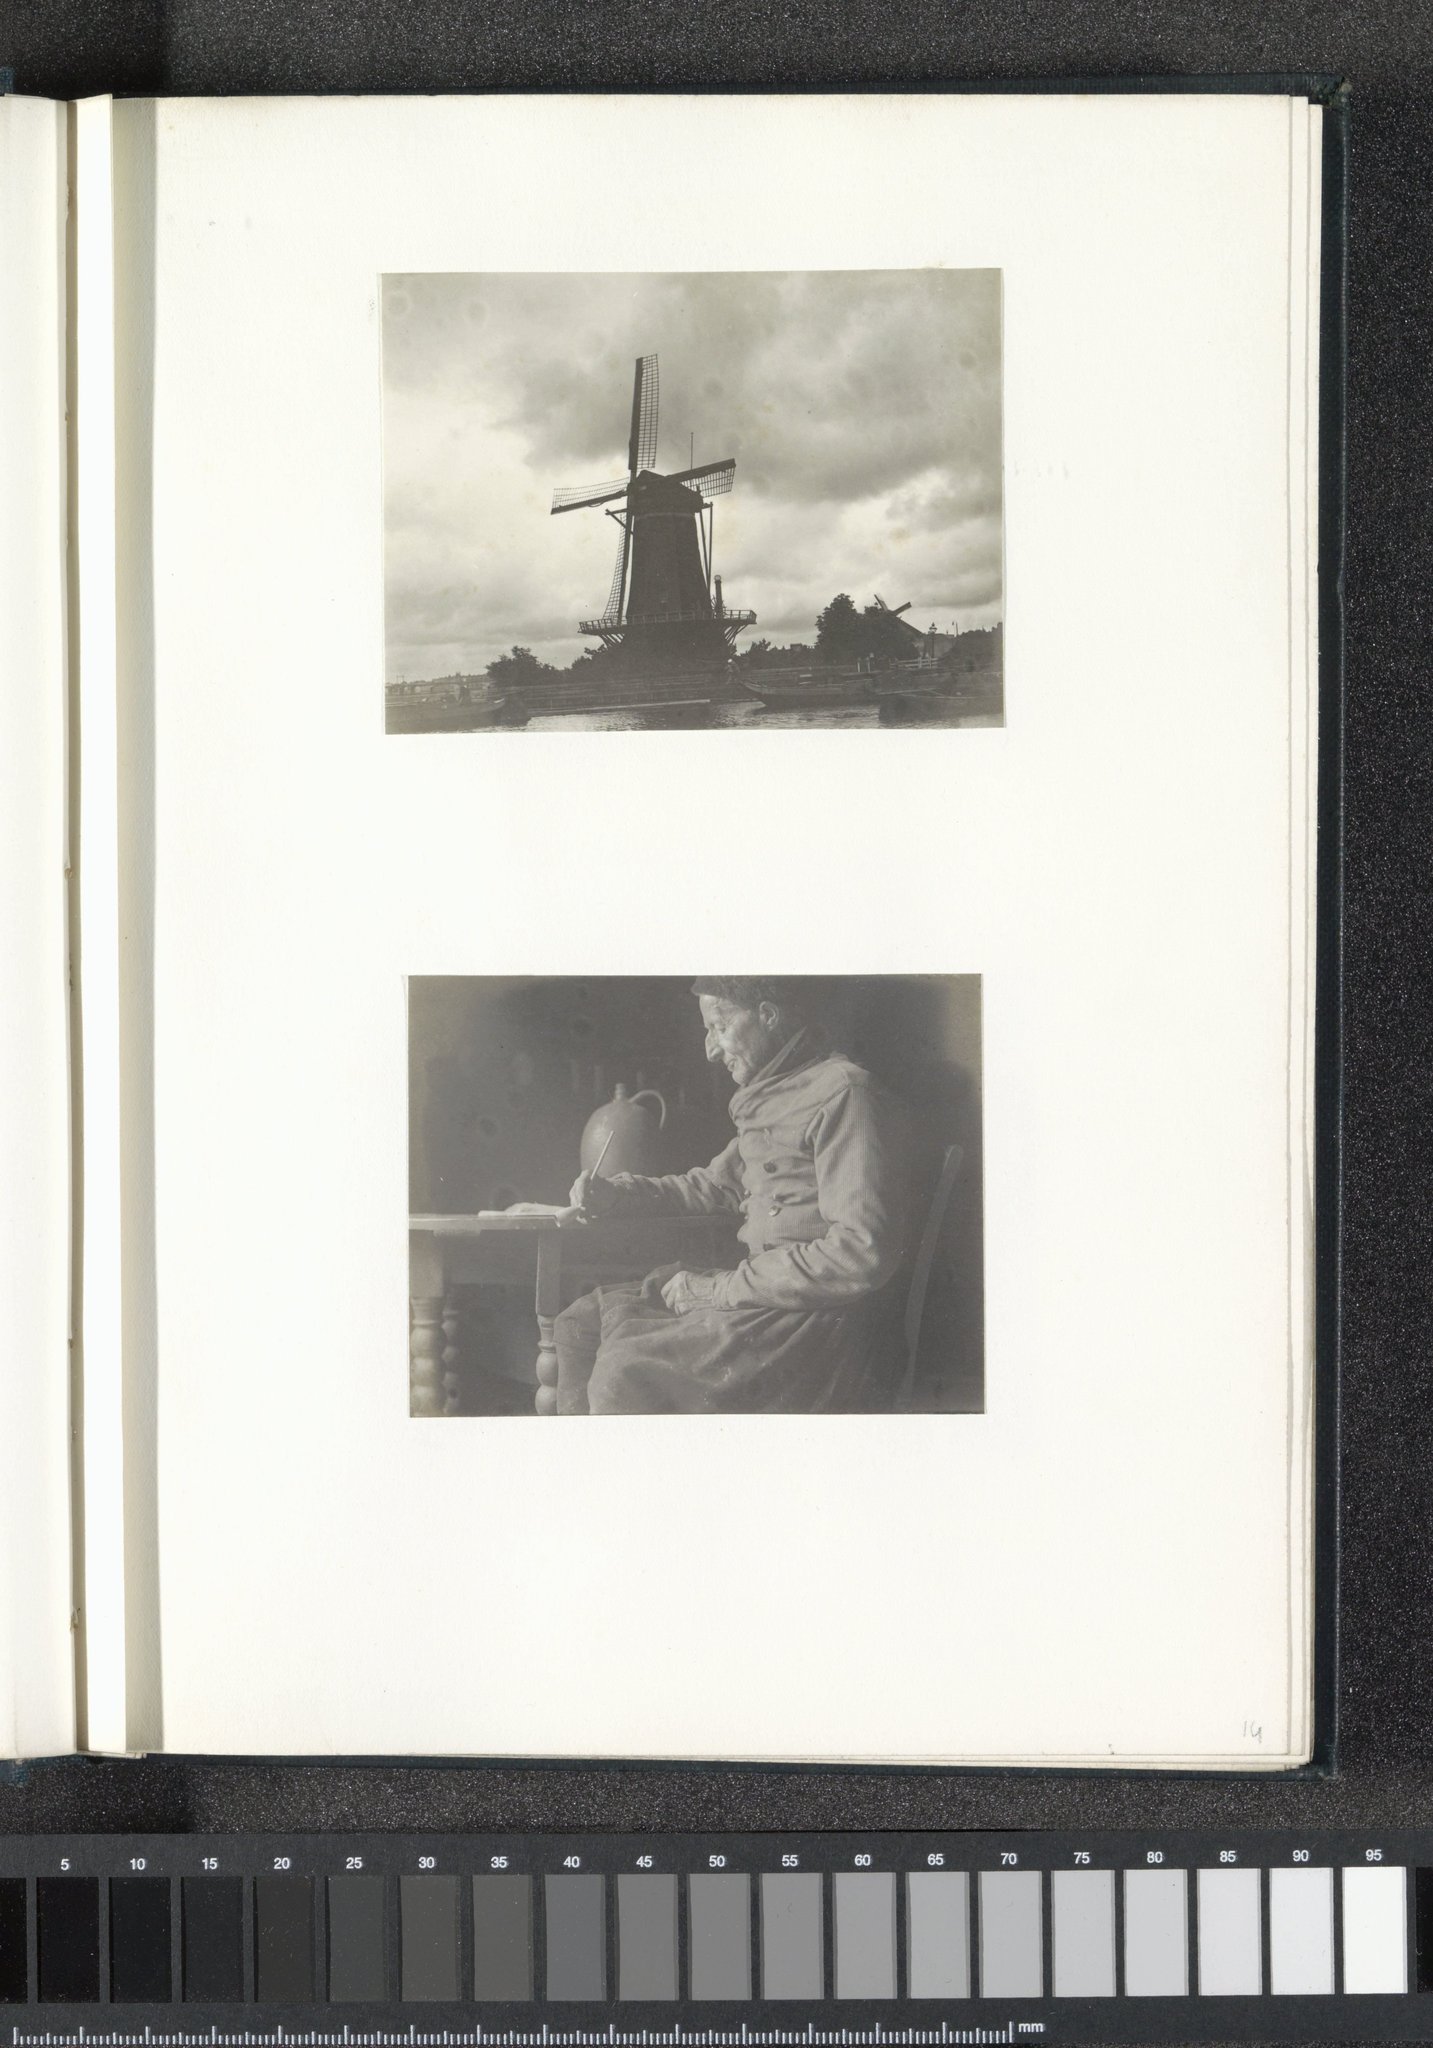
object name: photograph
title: Portret van een man in Volendamse klederdracht, zittend aan een tafel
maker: george hidderley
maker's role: fotograaf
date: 1900-1910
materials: paper, photographic support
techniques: gelatin silver print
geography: volendam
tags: sitting figure, pipe ~ tobacco, folk costume, regional costume, container of ceramics: jar, jug, pot, vase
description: Onderdeel van fotoalbum met opnames van Volendam, Dordrecht, Gorinchem en Woudrichem.